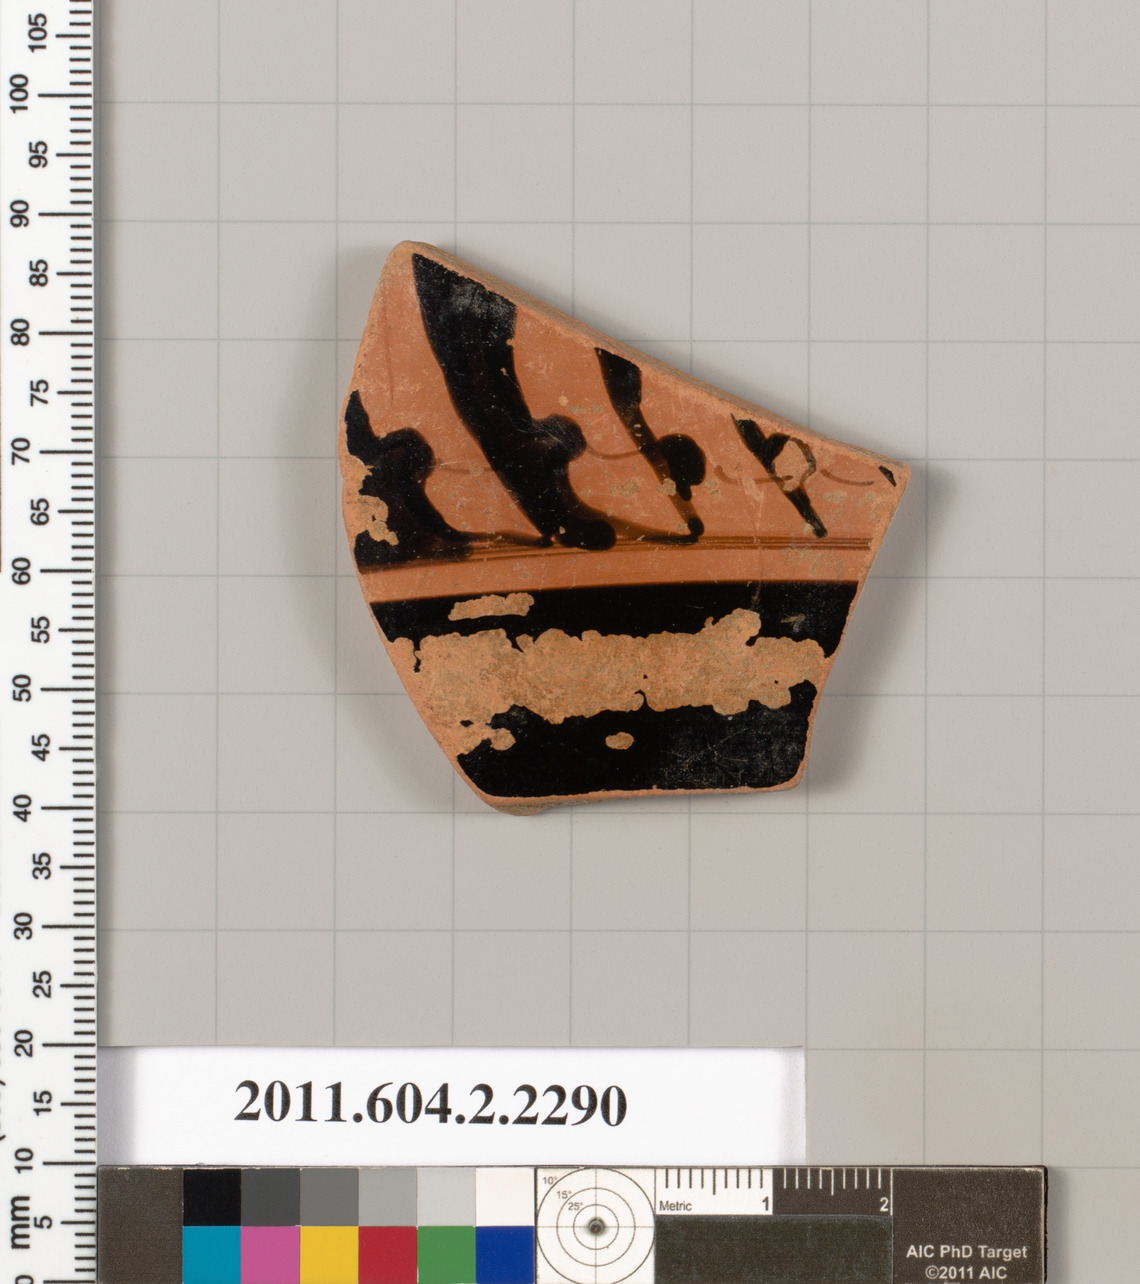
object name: column krater fragment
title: Terracotta fragment of a column-krater (bowl for mixing wine and water)?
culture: greek, attic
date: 460-440 BCE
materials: terracotta